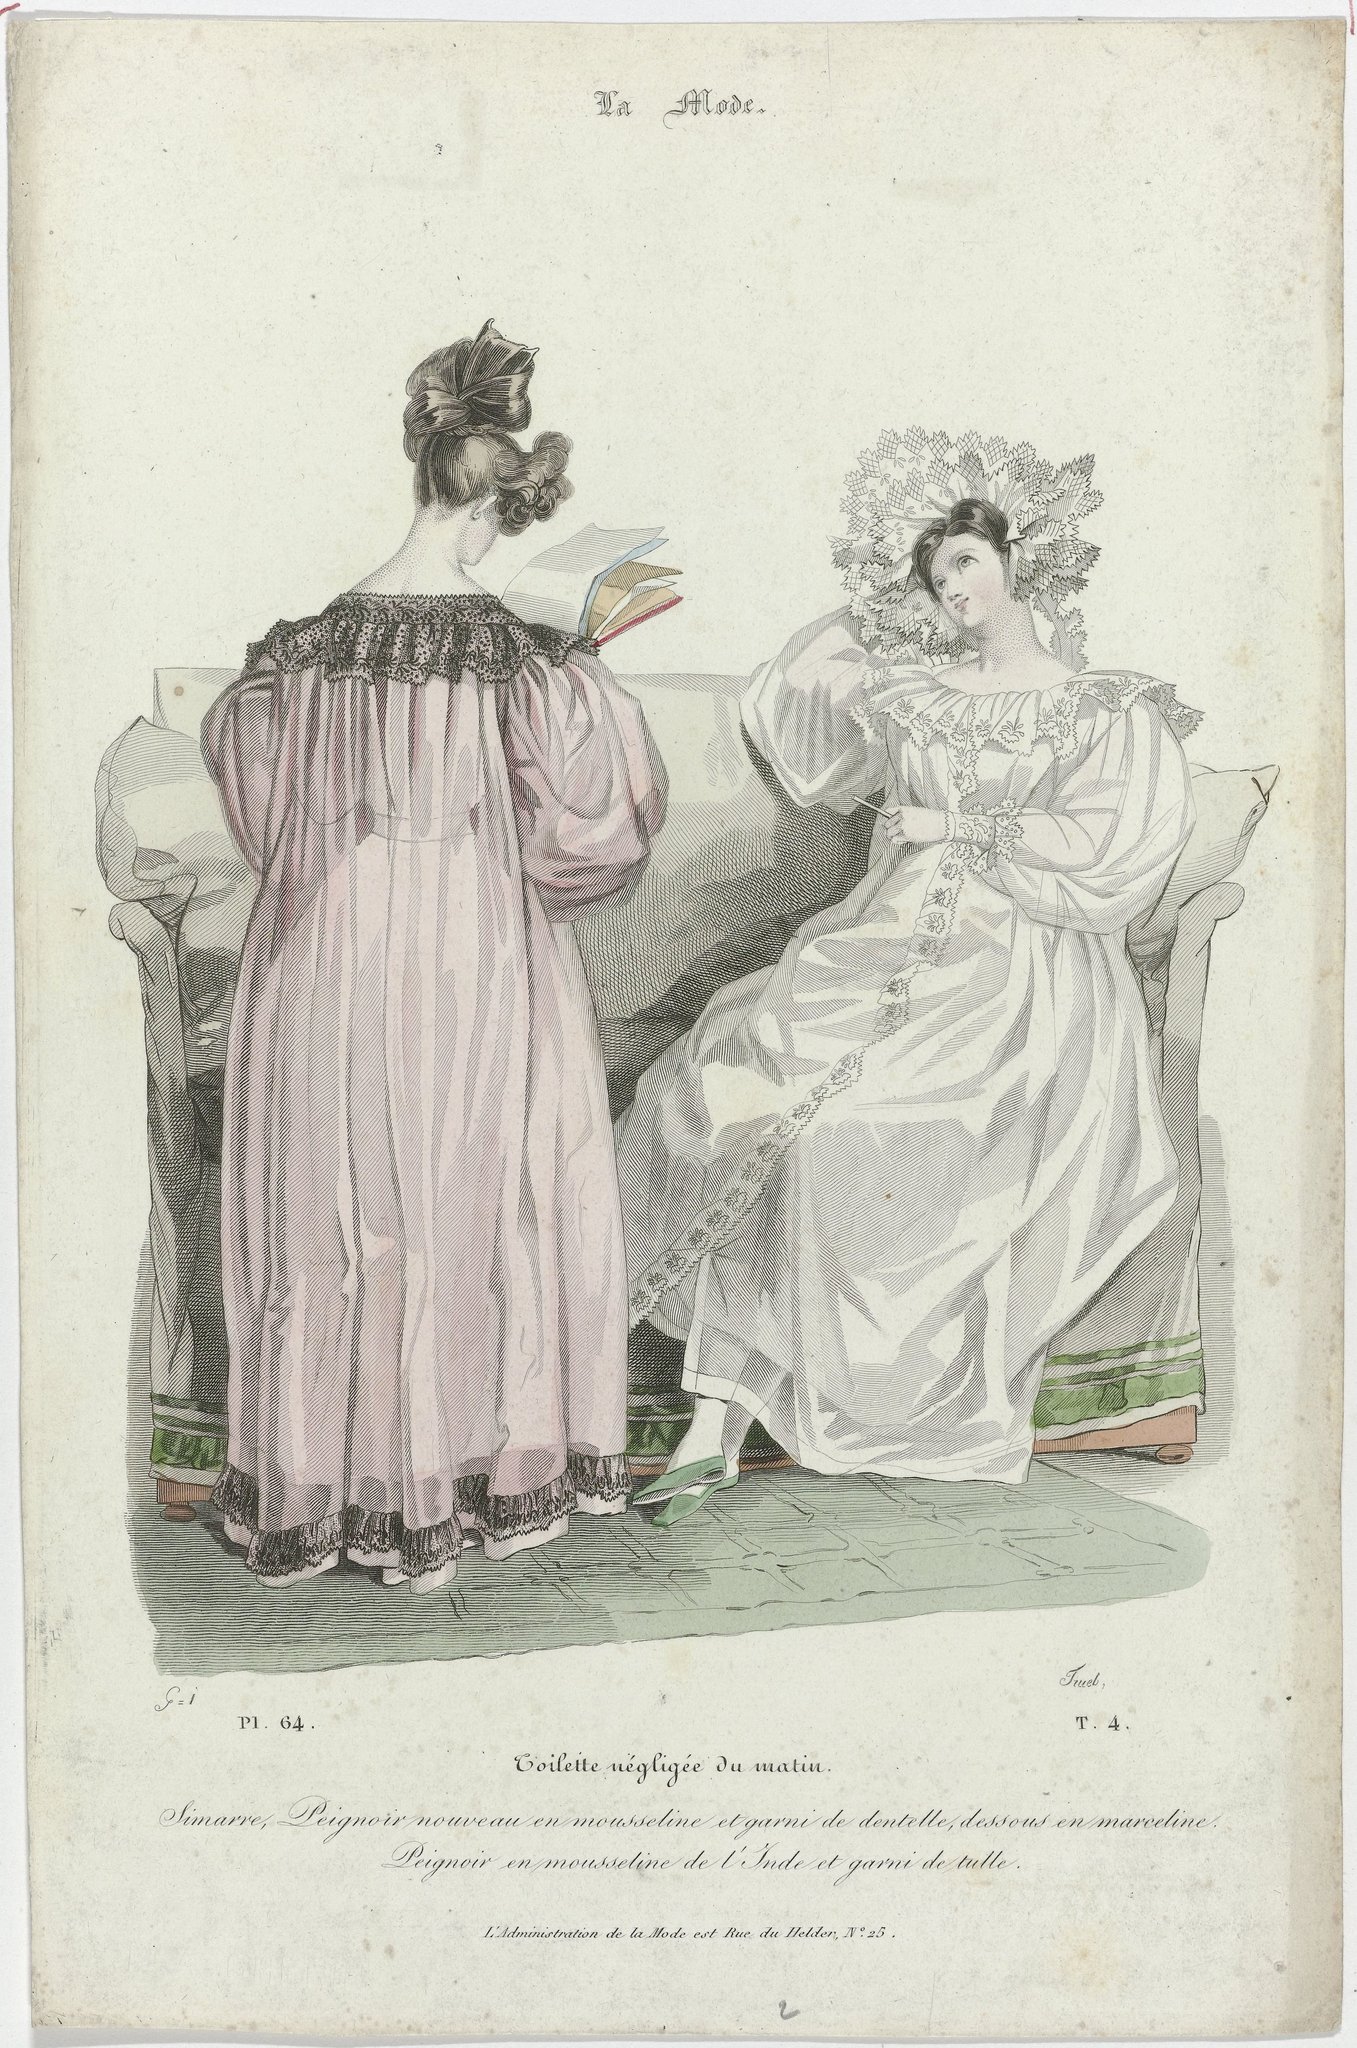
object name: fashion print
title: La Mode, 1830, Pl. 64, T.4: Toilette négligée du matin (...)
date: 1830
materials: paper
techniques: etching, hand coloring, engraving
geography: paris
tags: lace (+ women's clothes), coat (housecoat) (+ women's clothes), head-gear: cap (+ women's clothes), fashion plates, shoes, sandals (+ women's clothes)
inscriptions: caption: ‘Toilette négligée du matin. / Simarre, peignoir nouveau en mousseline et garni de dentelle, dessous en marceline. Peignoir en mousseline de l'Inde et garni de tulle.’, address: ‘L'Administration de la Mode est Rue du Helder, No. 25.’, title: ‘La Mode.’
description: 'Toilette négligée du matin'. Twee vrouwen bij een sofa. Links: 'simarre', nieuwe 'peignoir' van mousseline versierd met kant, waaronder 'marceline'. Rechts: 'peignoir' van 'mousseline de l'Inde' en versierd met tule. Prent uit het modetijdschrift La Mode (1829-1855).